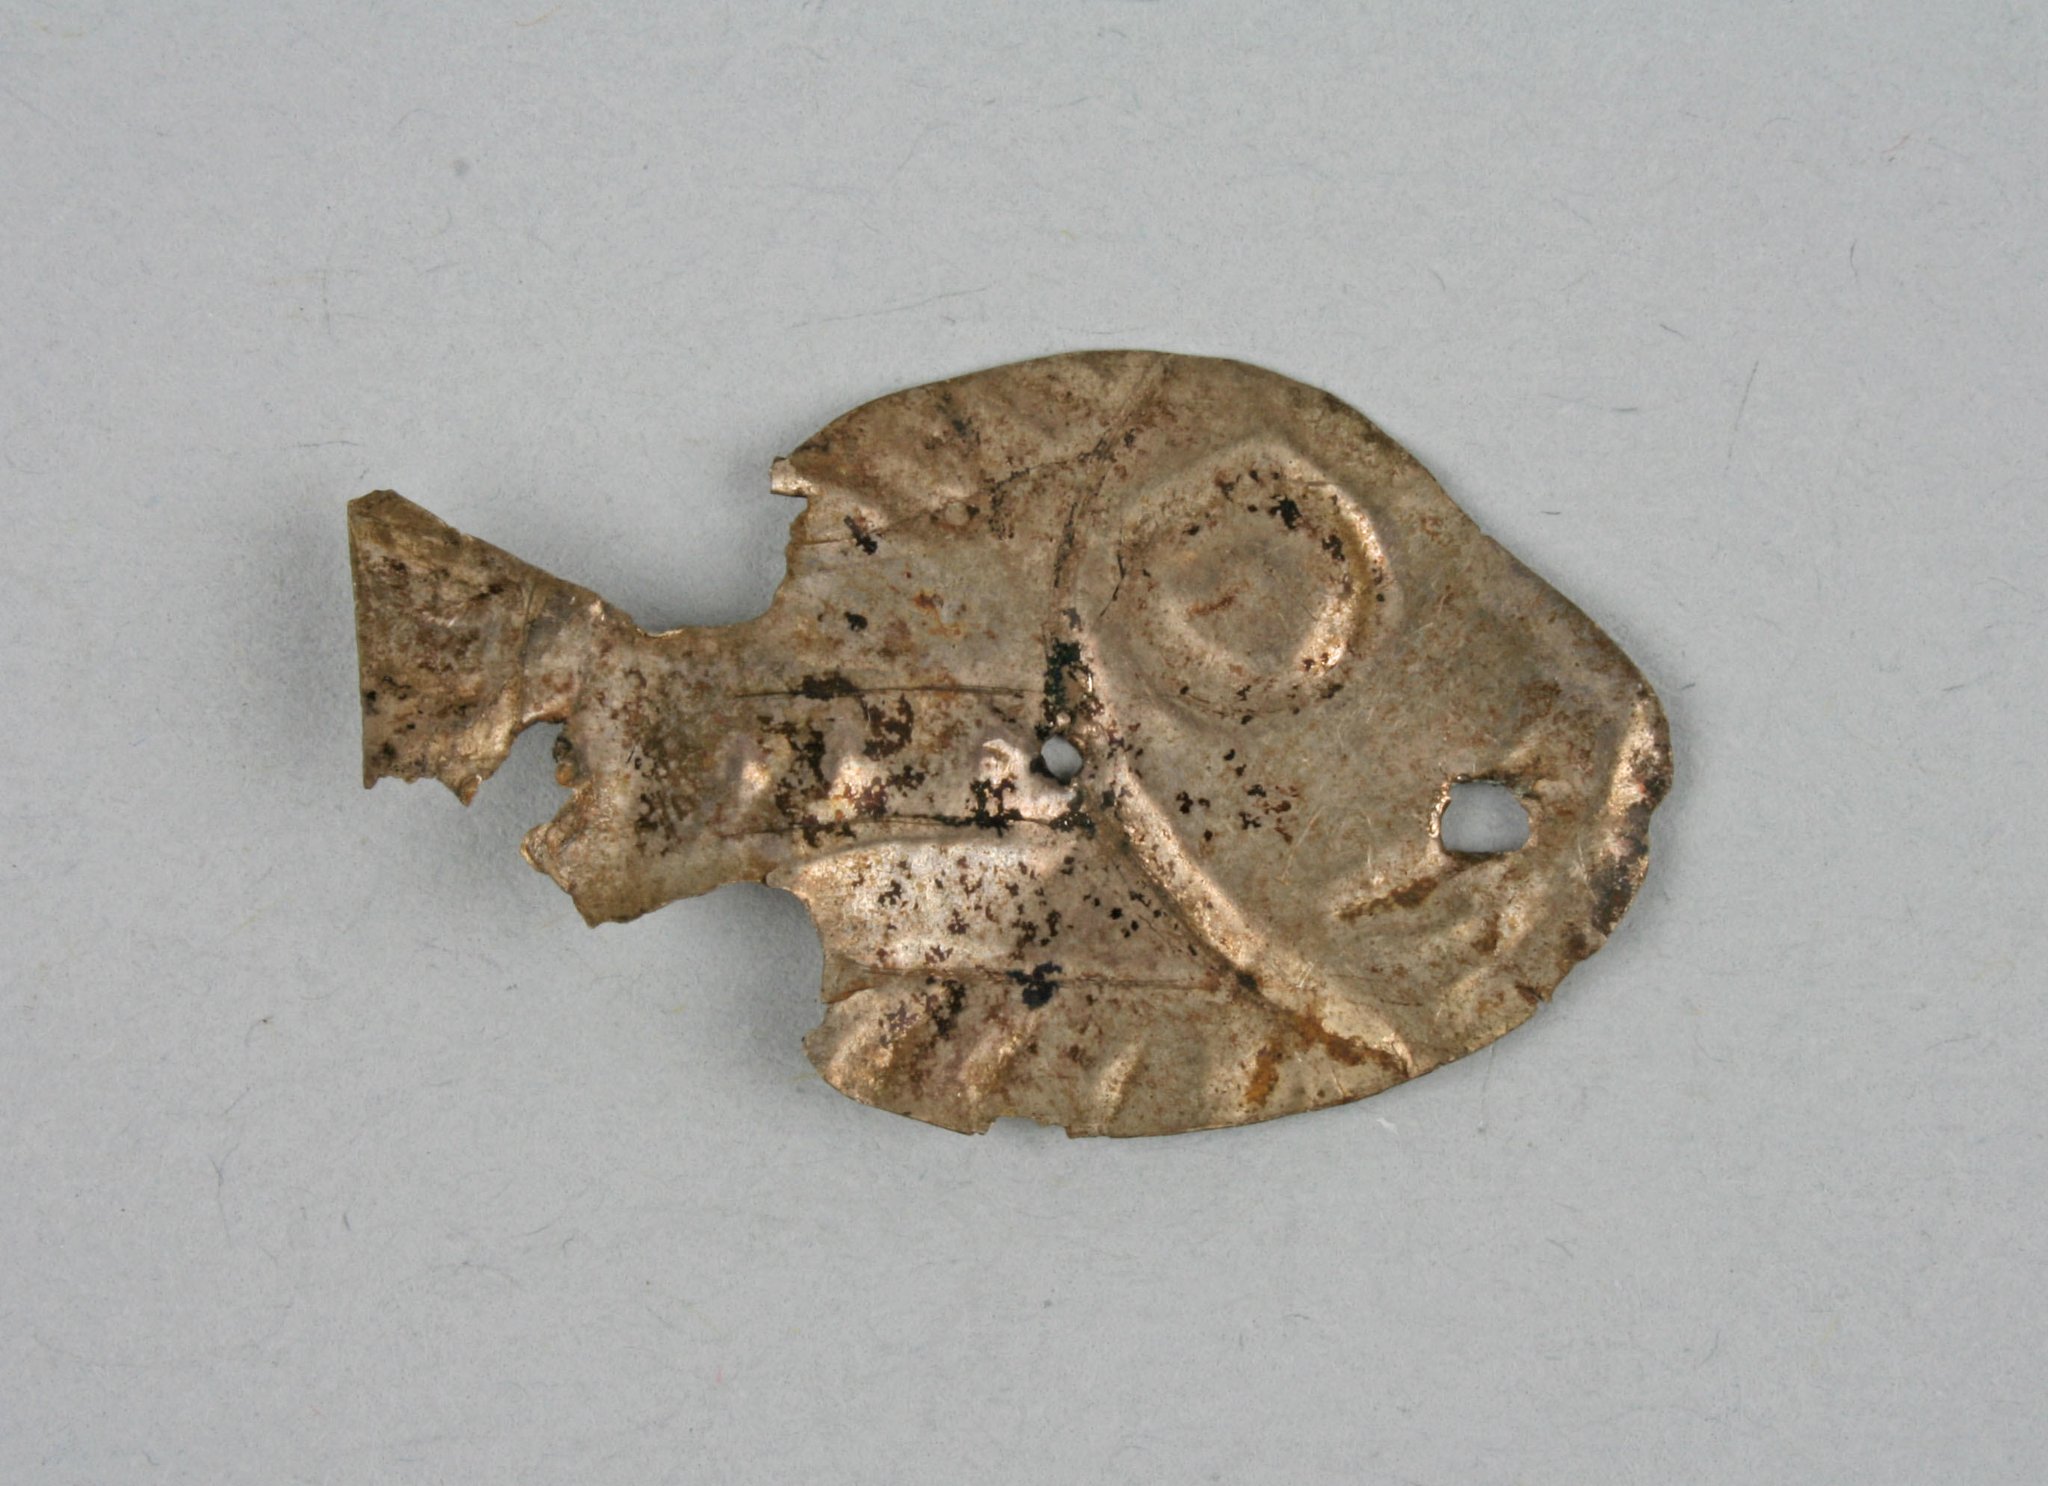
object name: ornament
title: Costume Ornament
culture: central coast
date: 1001-1200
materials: silver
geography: peru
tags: fish